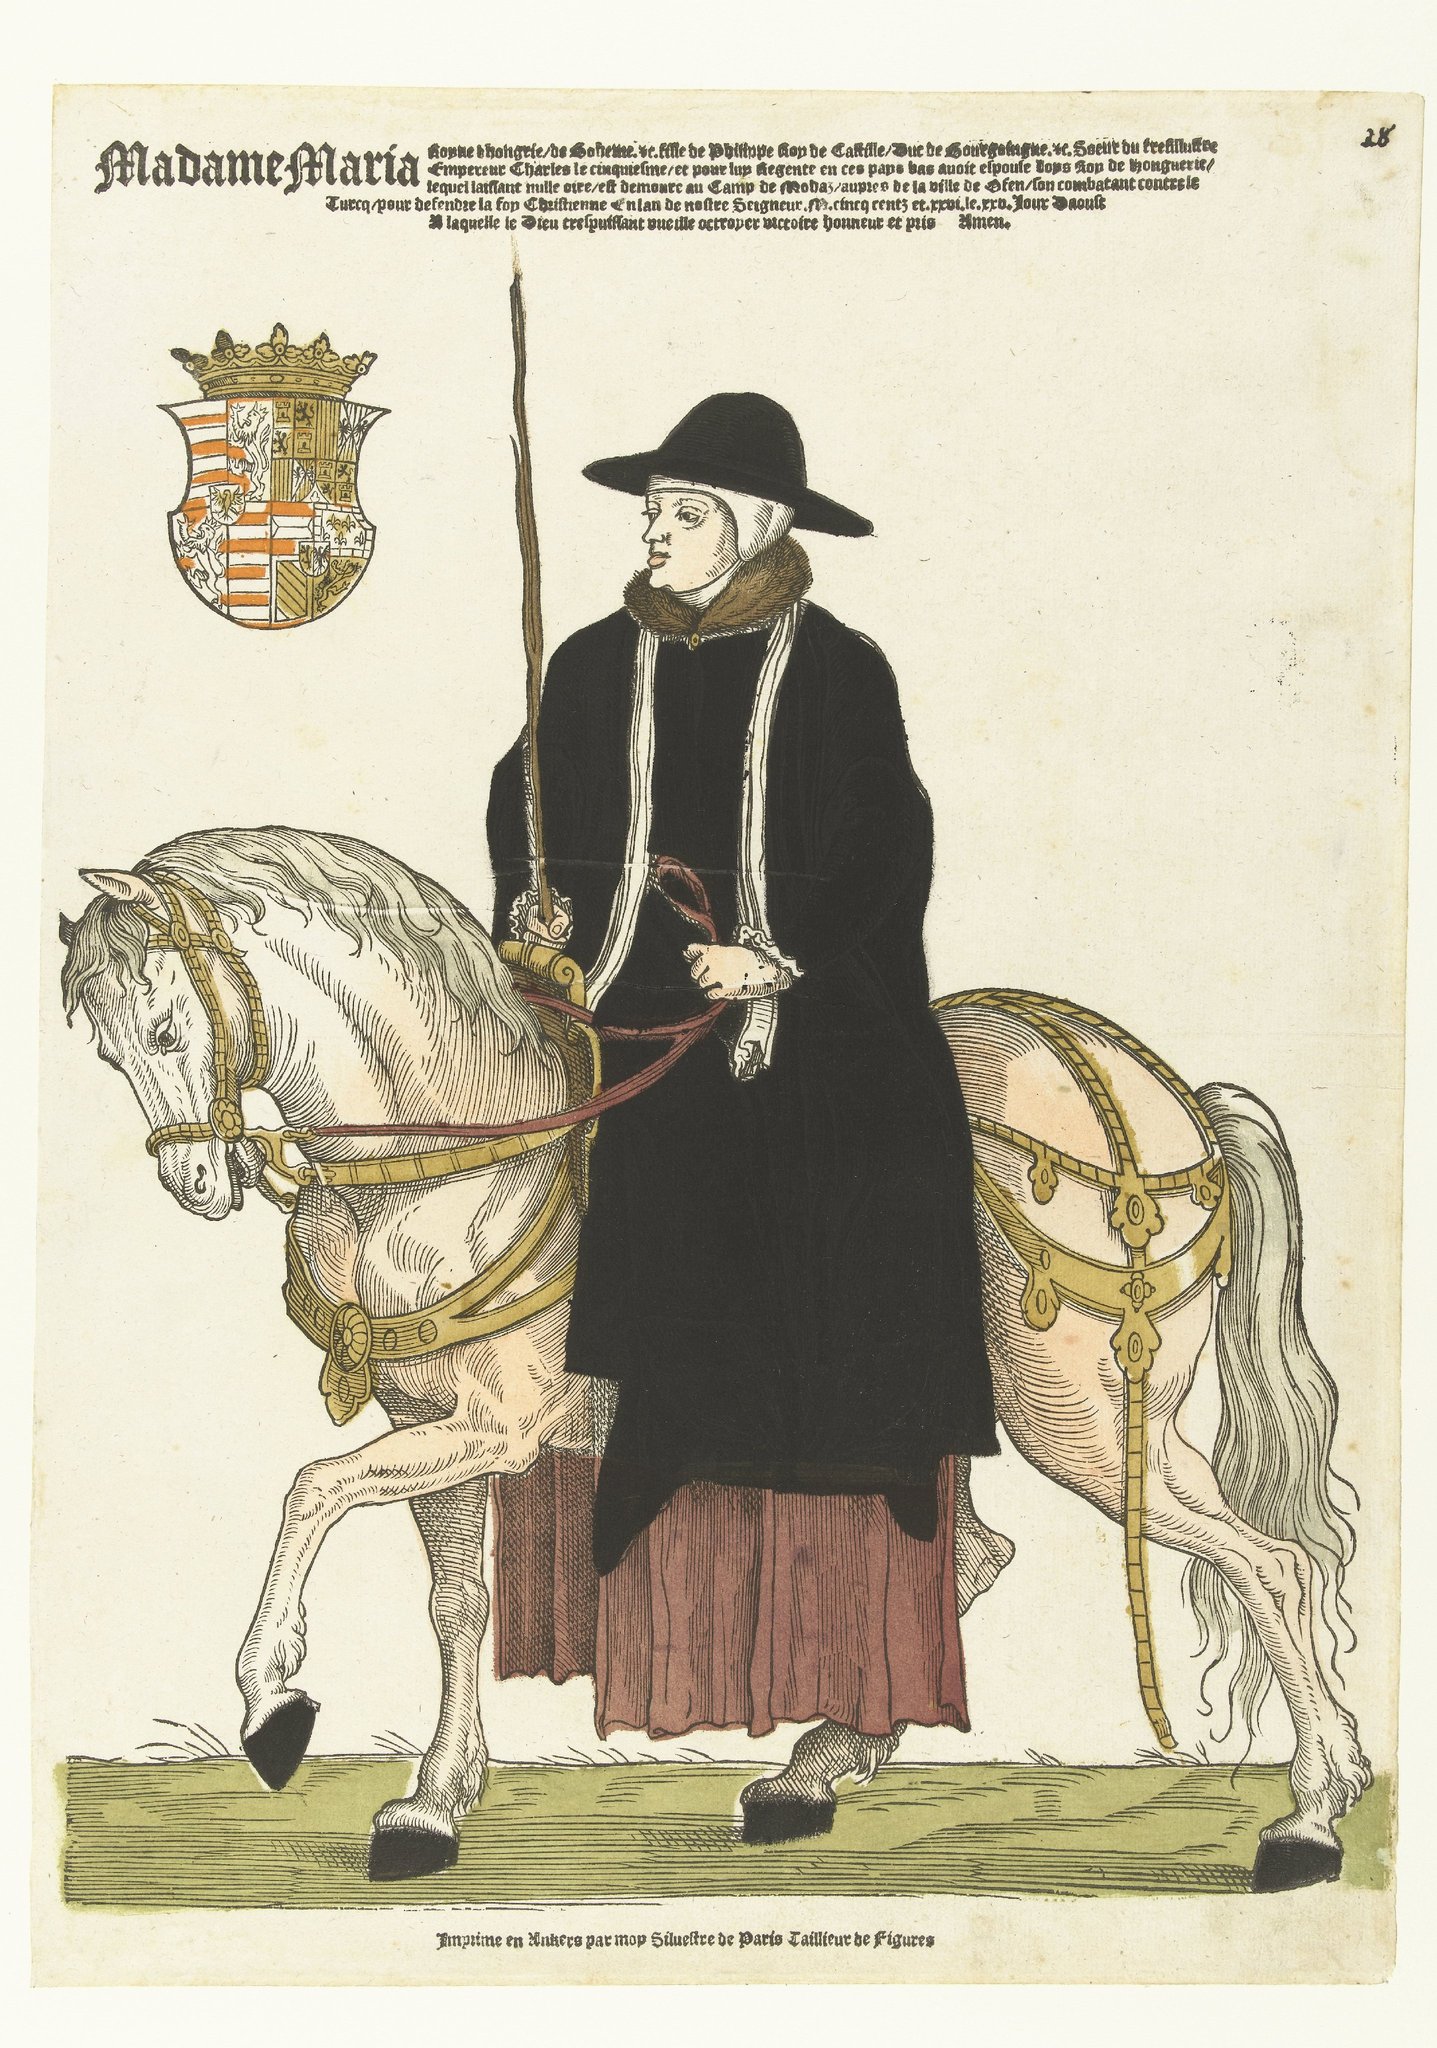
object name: print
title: Portret van Maria van Hongarije te paard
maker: sylvester van parijs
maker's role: publisher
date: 1538-1553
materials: paper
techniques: hand coloring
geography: antwerp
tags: brussels, maria van hongarije (landvoogdes der nederlanden), equestrian state-portrait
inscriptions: number: ‘28’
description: Maria van Hongarije (1505-1558), jongere zuster van Karel V, koningin-weduwe van Hongarije, van 1531 tot 1555 regentes der Nederlanden. Haar echtgenoot Lodewijk II van Hongarije sneuvelde in 1526 in de slag bij Mohacz tegen de Turken. De regentes ging sinds dat jaar in het zwart gekleed met de witte weduwekap. Zij is zo herhaaldelijk afgebeeld in busteportretten. Hier is zij afgebeeld als amazone in reiskleding op een stappend paard naar rechts. Linksboven haar wapen.